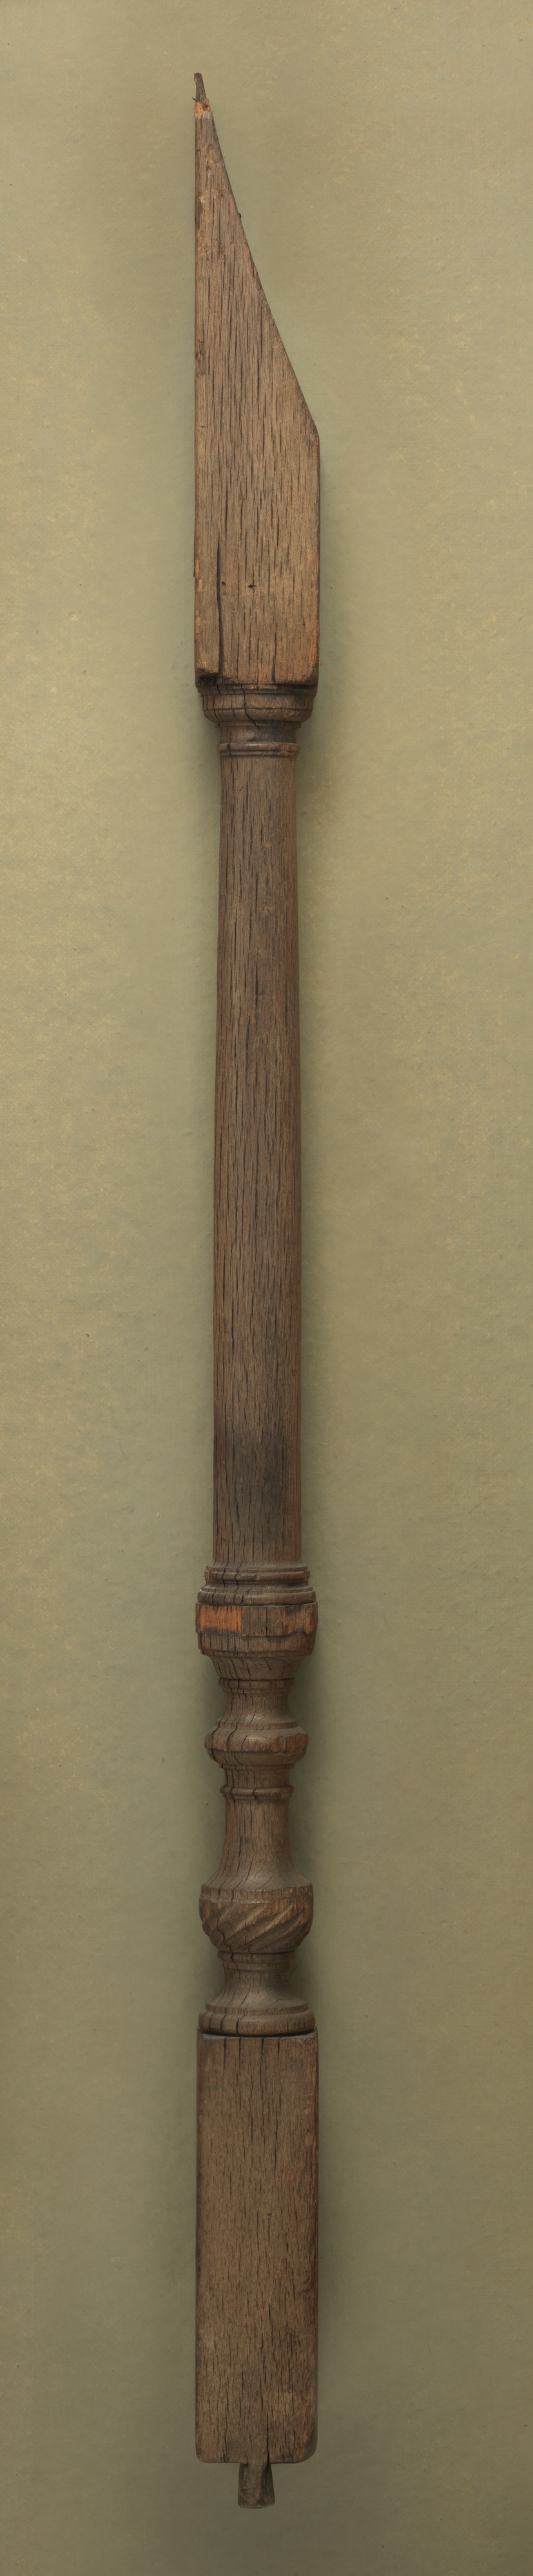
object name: baluster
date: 1734-1766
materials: wood